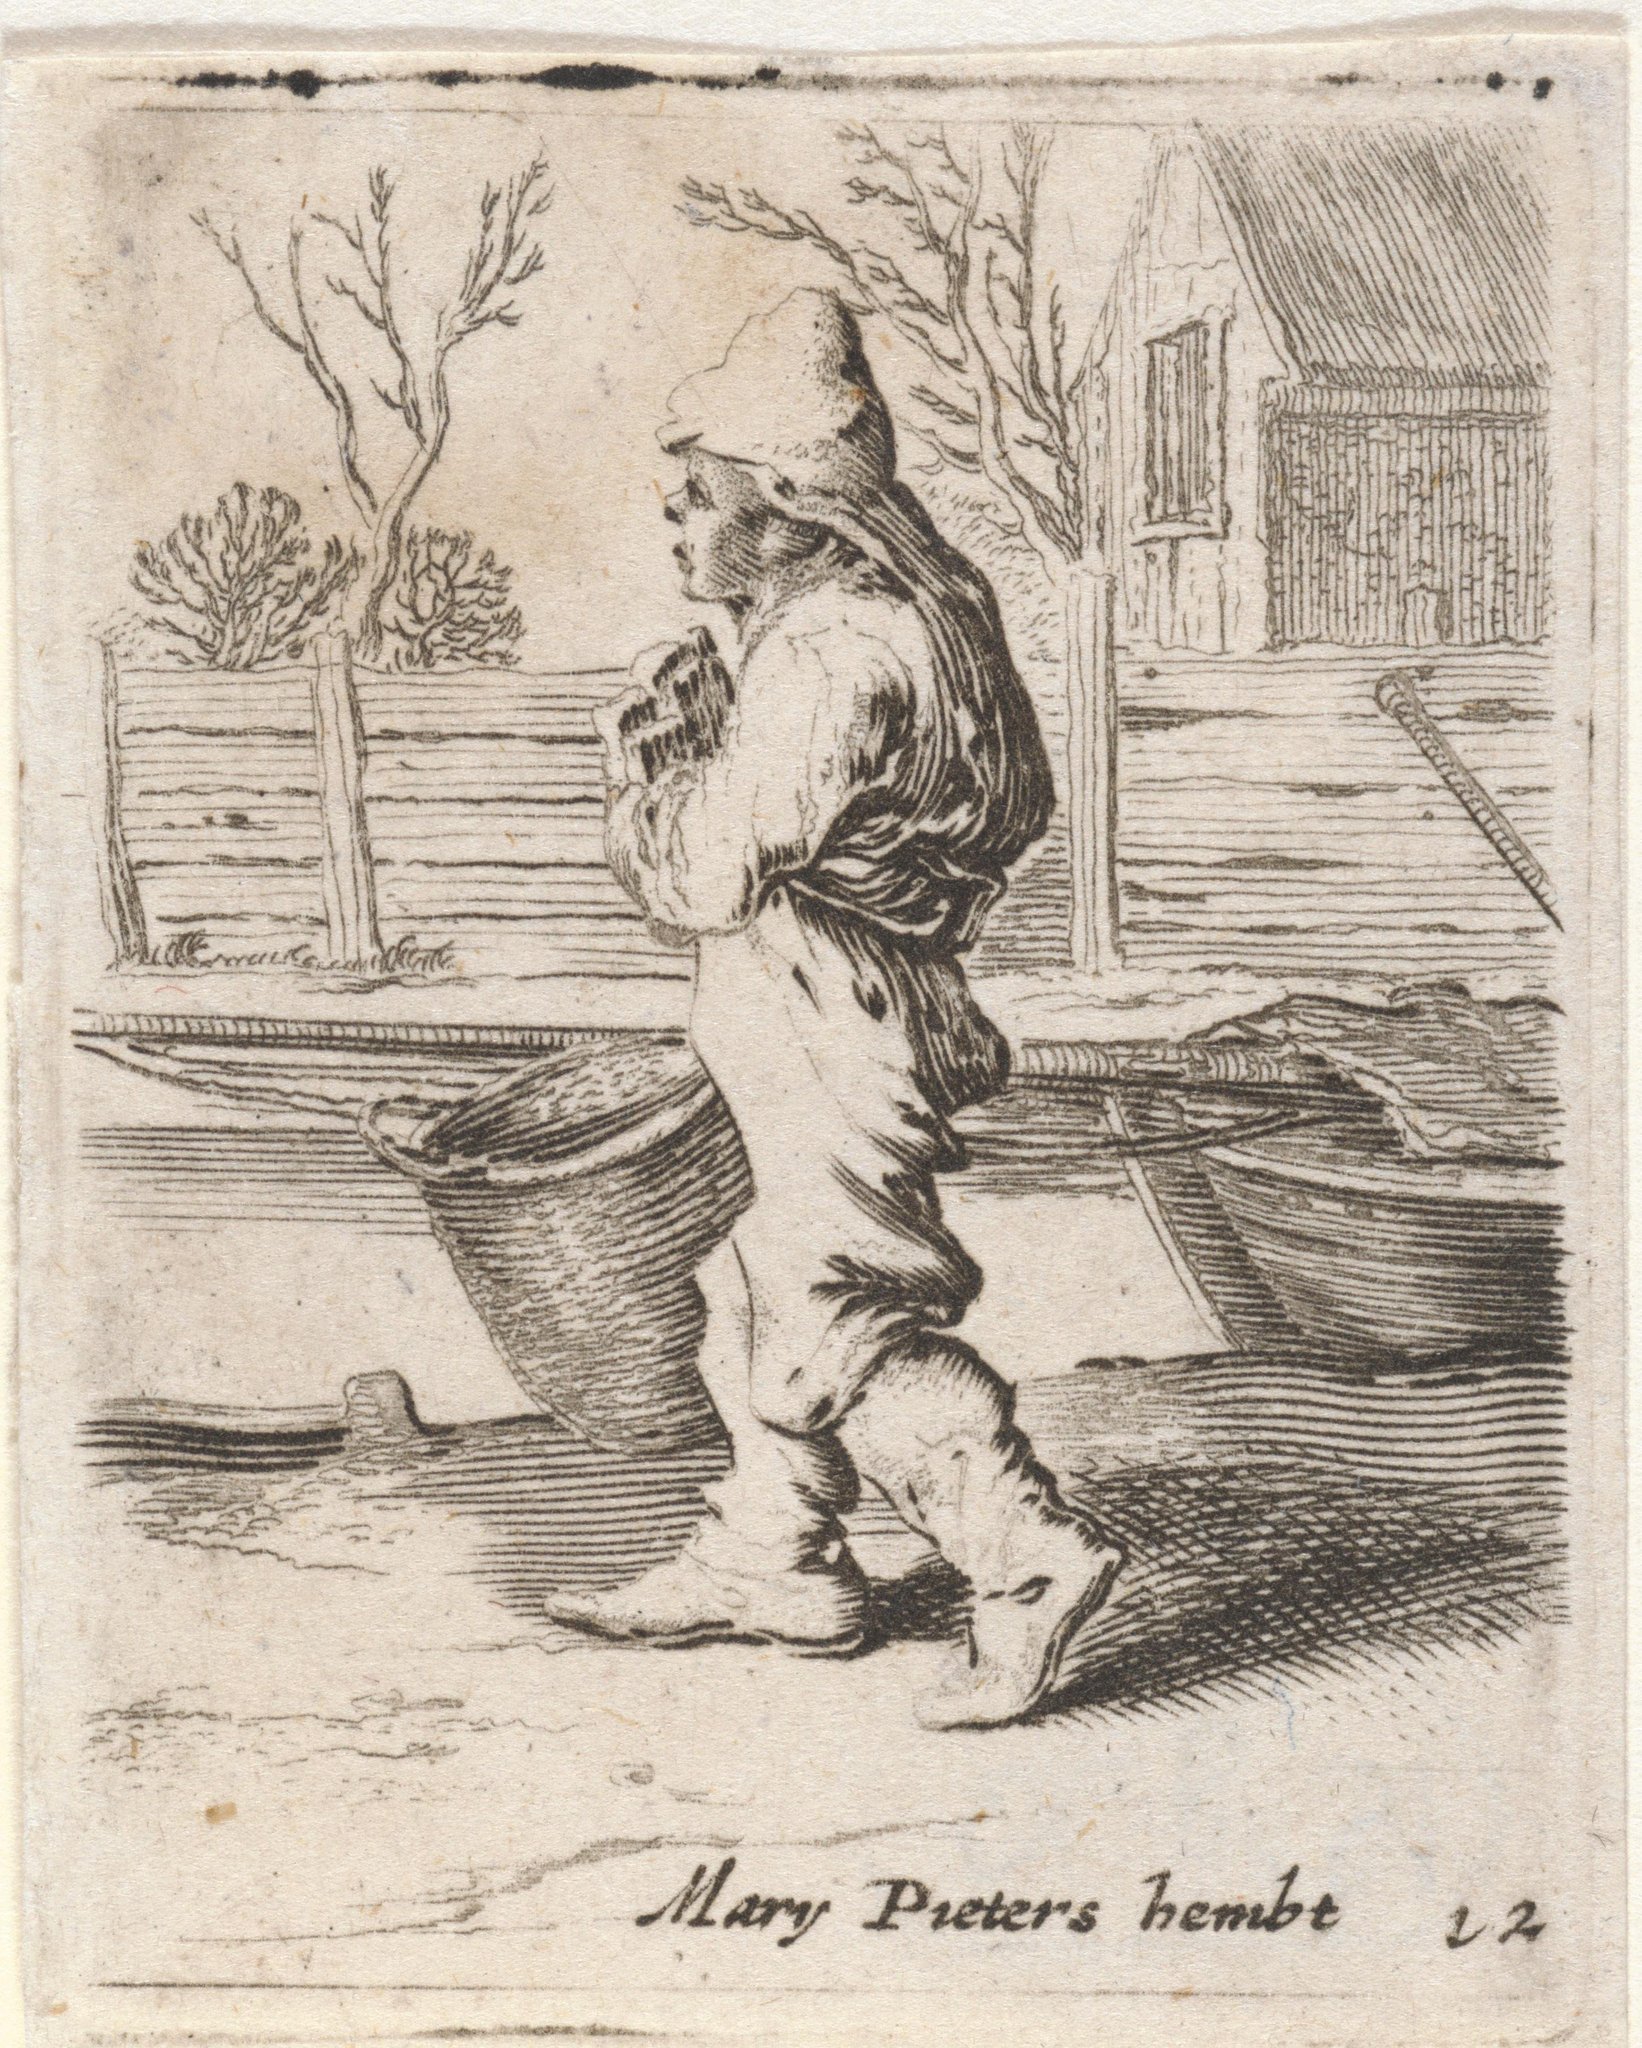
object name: print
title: Mary Pieters hembt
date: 1603-1706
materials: paper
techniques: engraving, etching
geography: netherlands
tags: fence, wall, paling, farmers, farm (building)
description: Een boer loopt langs een vaart, waar een rieten mand naast staat. Op de achtergrond een schutting en een boerderij. De prent maakt deel uit van een serie van 32 prenten met genretaferelen.